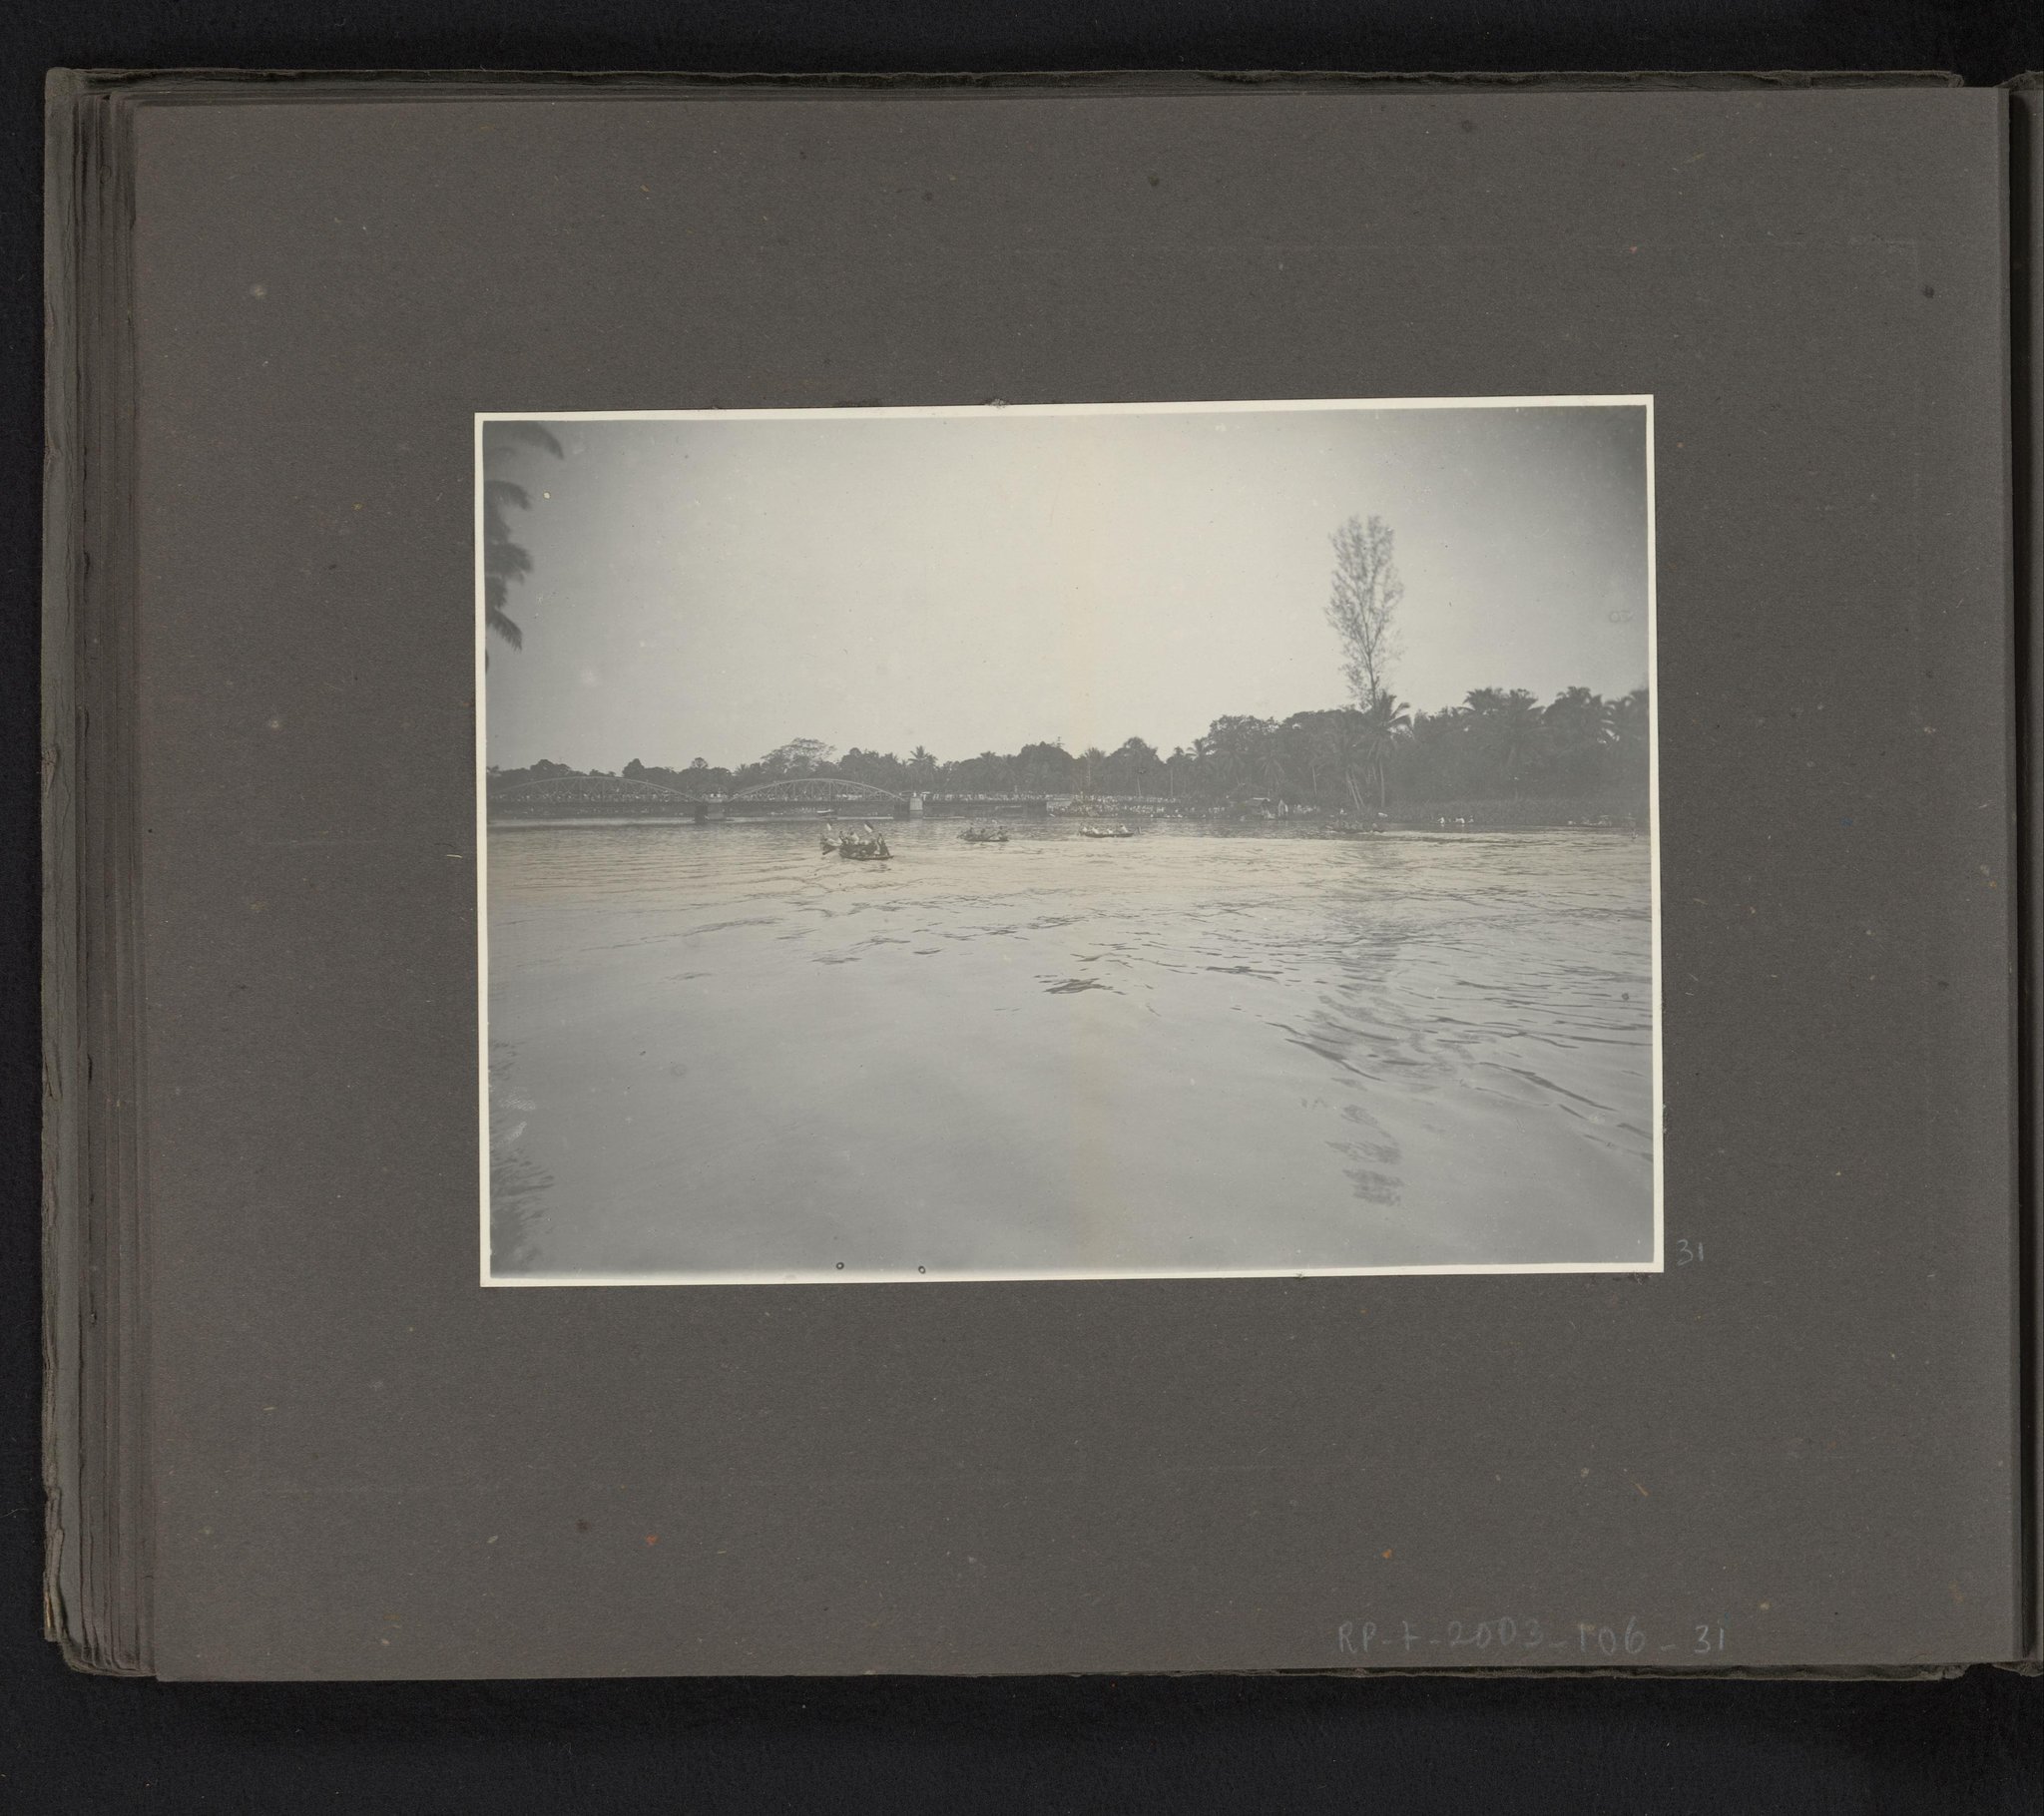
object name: album leaf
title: Roeiwedstrijden op de Wampoerivier bij het jubileum van de Sultan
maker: Anonymous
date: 1919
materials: photographic support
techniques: gelatin silver print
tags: river, historical persons, rowing, canoeing, etc. (sport)